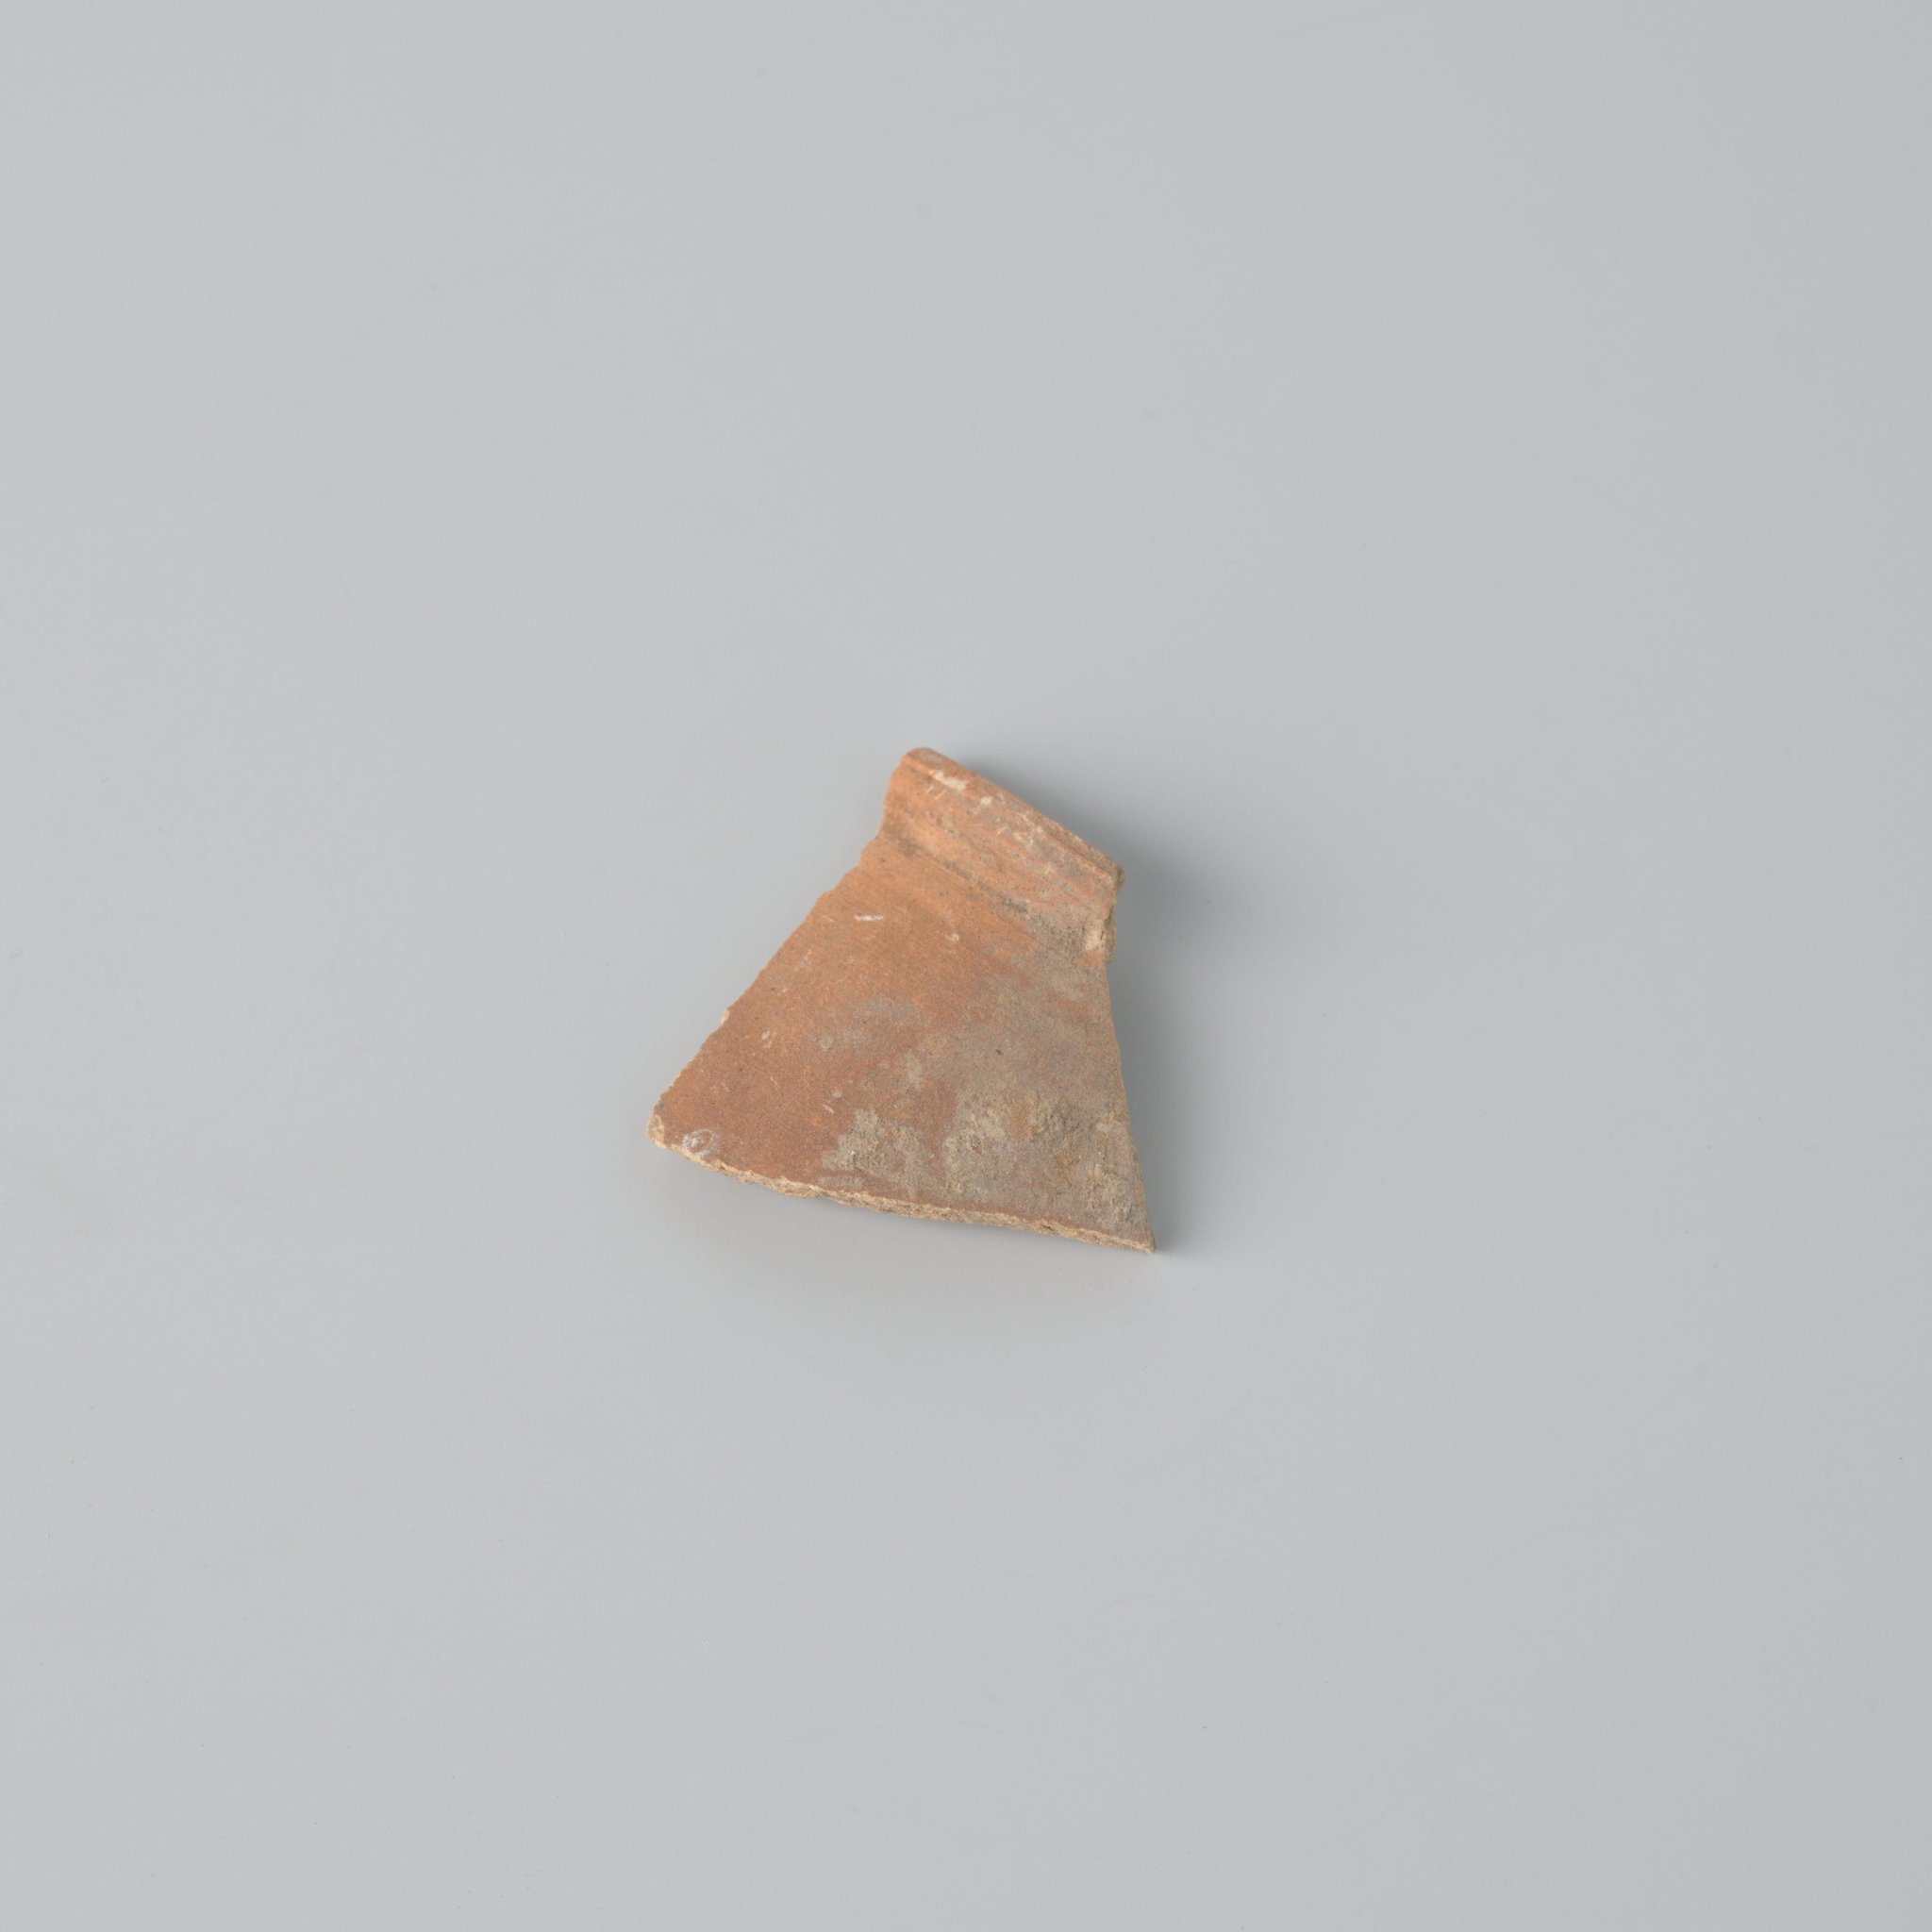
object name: fragment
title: Scherf (De Caluwe bakafval)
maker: jacobus de caluwe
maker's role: plateelbakkerij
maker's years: -1730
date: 1700-1725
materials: earthenware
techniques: firing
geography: delft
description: Toegeschreven aan Jacobus de Caluwe, omdat dit voorwerp samen met gemerkte stukken (‘Jacobus De Caluwe’ en rennend hert) gevonden is op de plaats waar zich De Caluwes tweede werkplaats bevond. Er is een duidelijke stilistische overeenkomst tussen de gemerkte en niet gemerkte voorwerpen uit deze archeologische vondst.